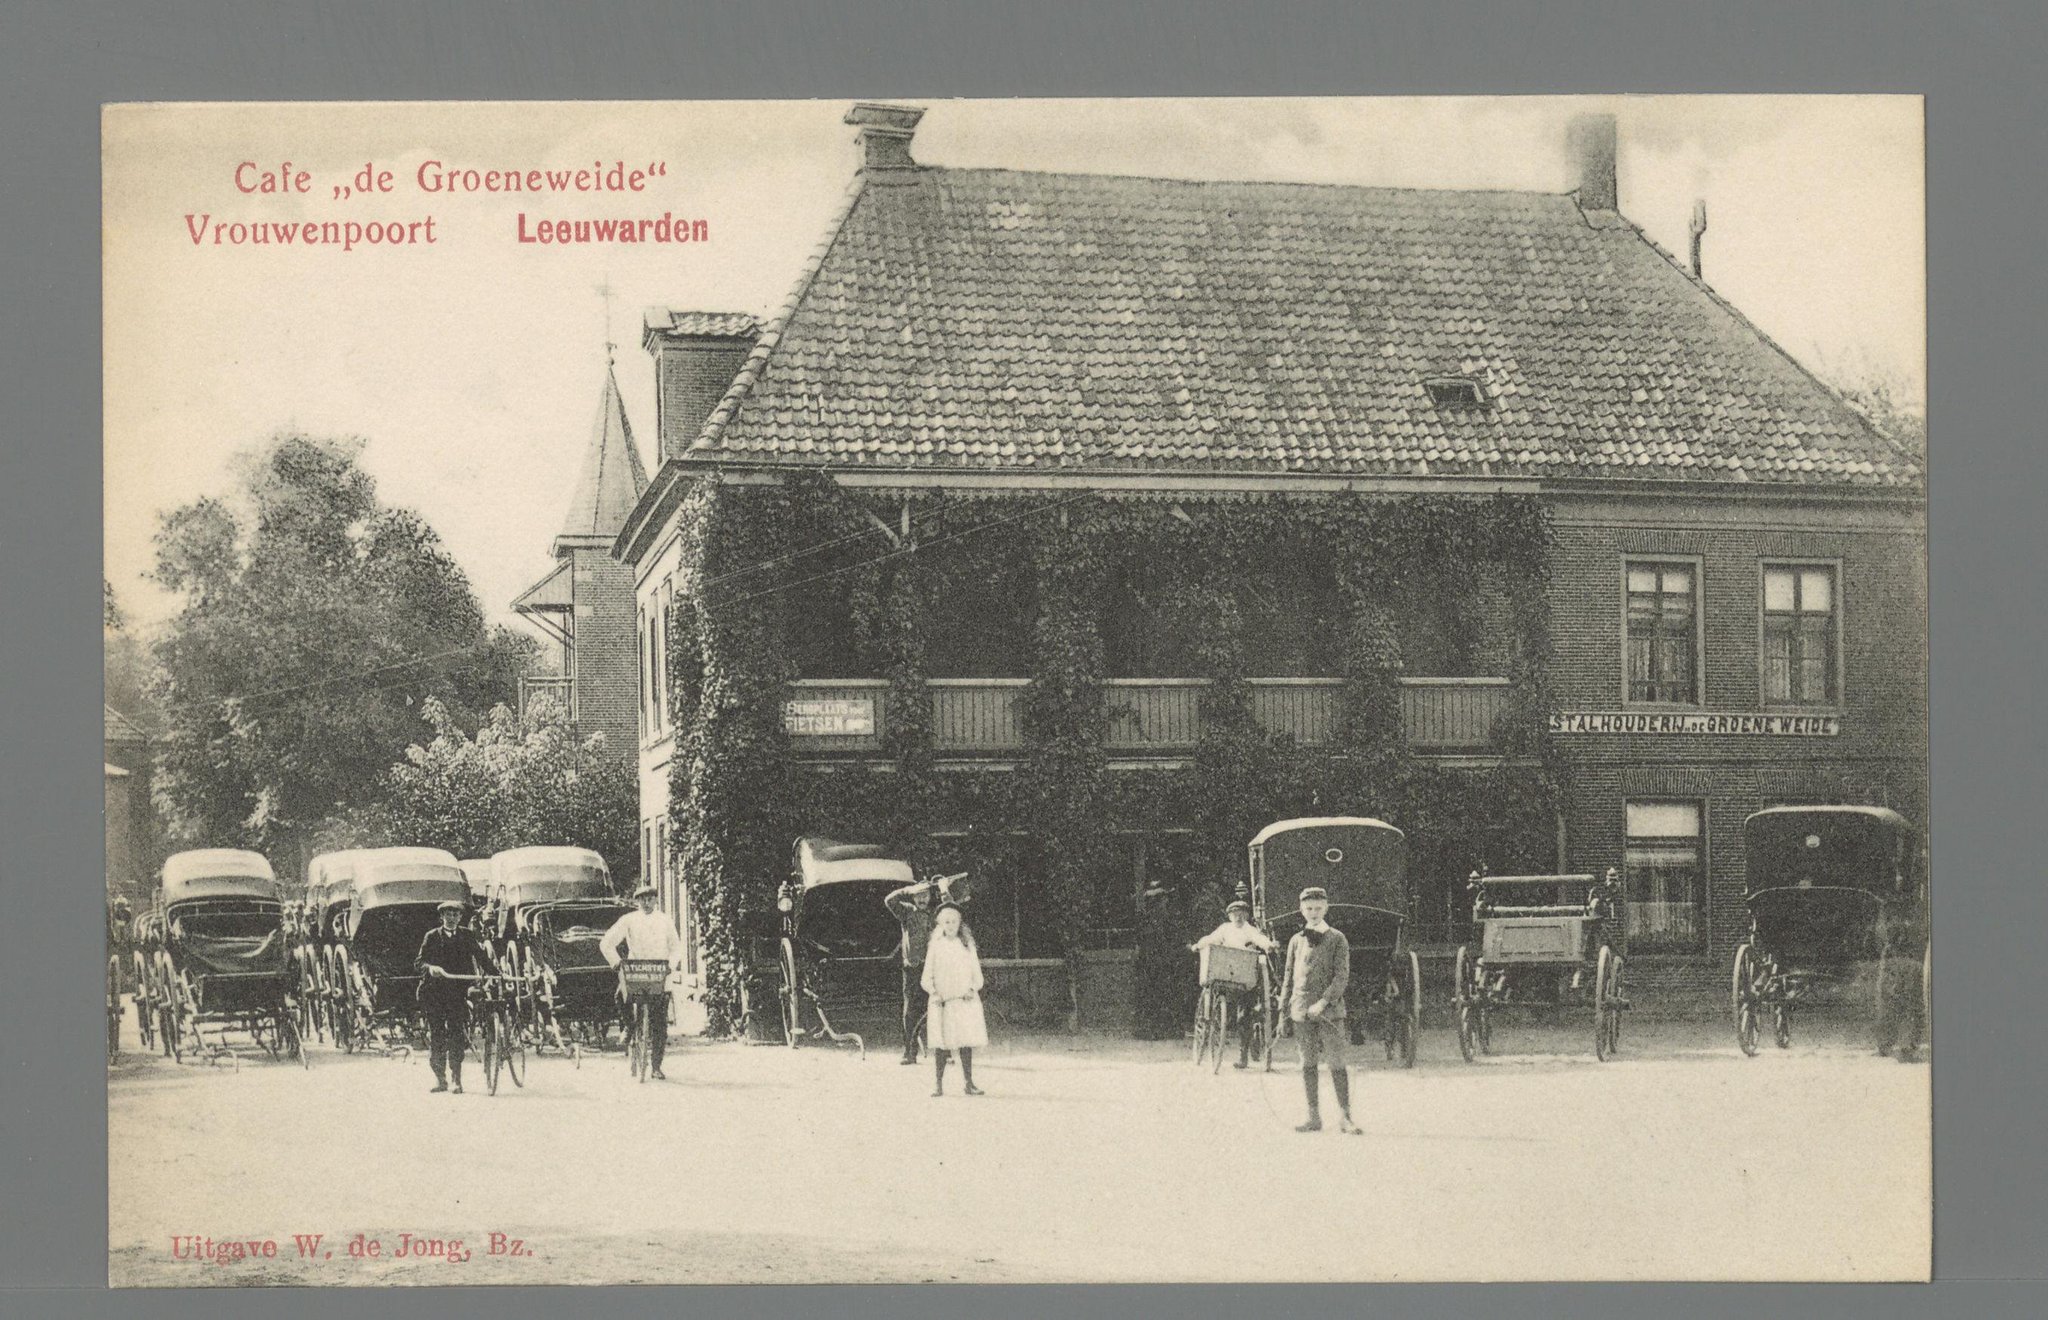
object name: ansichtkaart, prentbriefkaart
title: Cafe "de Groeneweide". Vrouwenpoort. Leeuwarden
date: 1905-1930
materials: cardboard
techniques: photograph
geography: leeuwarden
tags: animal traction, animal-drawn vehicle (carriage etc.), restaurant